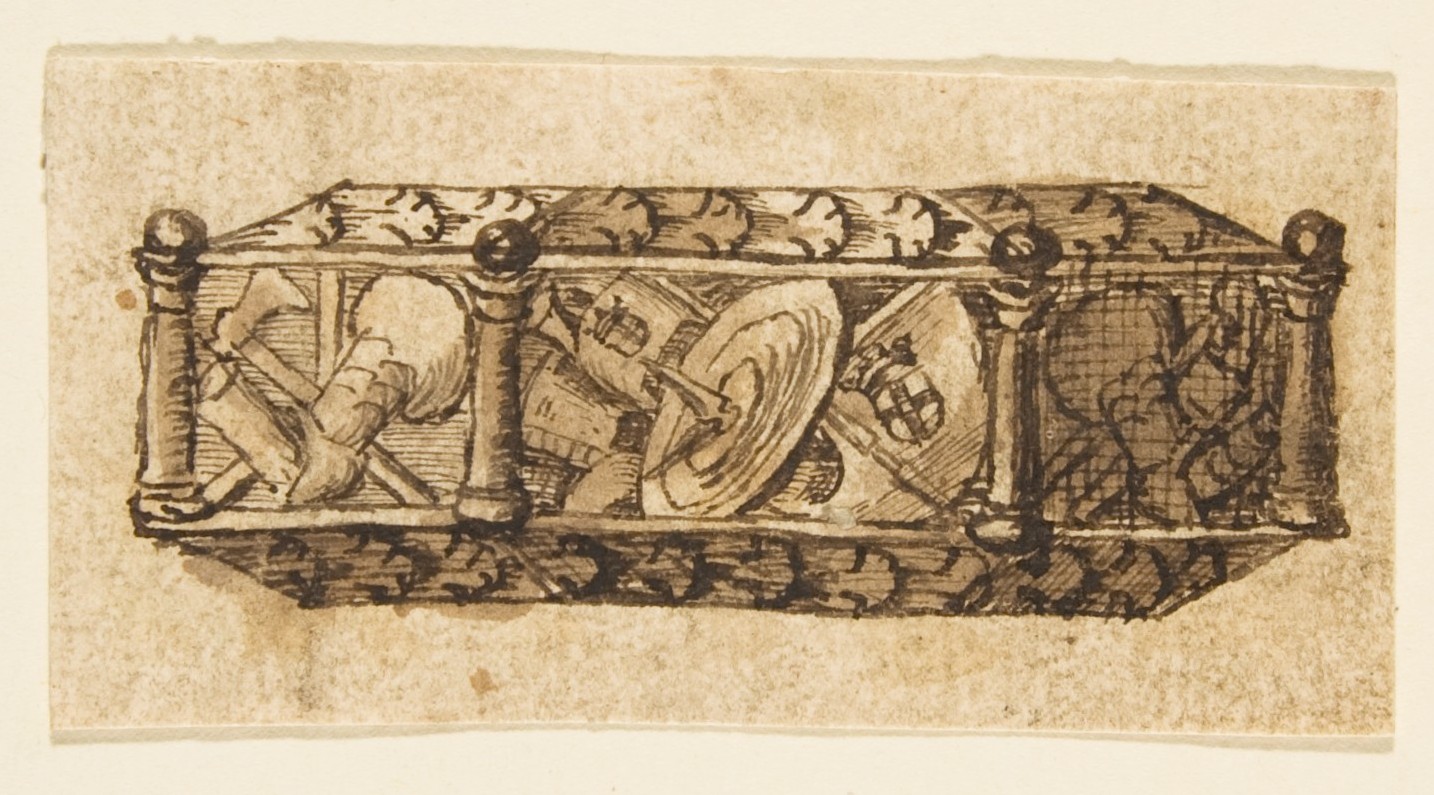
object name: drawing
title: Design for an Object (Casket?) Decorated with Armorial Trophies and Foliage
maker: anonymous, french, 19th century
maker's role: artist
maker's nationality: french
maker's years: 1800-1900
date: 1801-1900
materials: ink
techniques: pen, wash